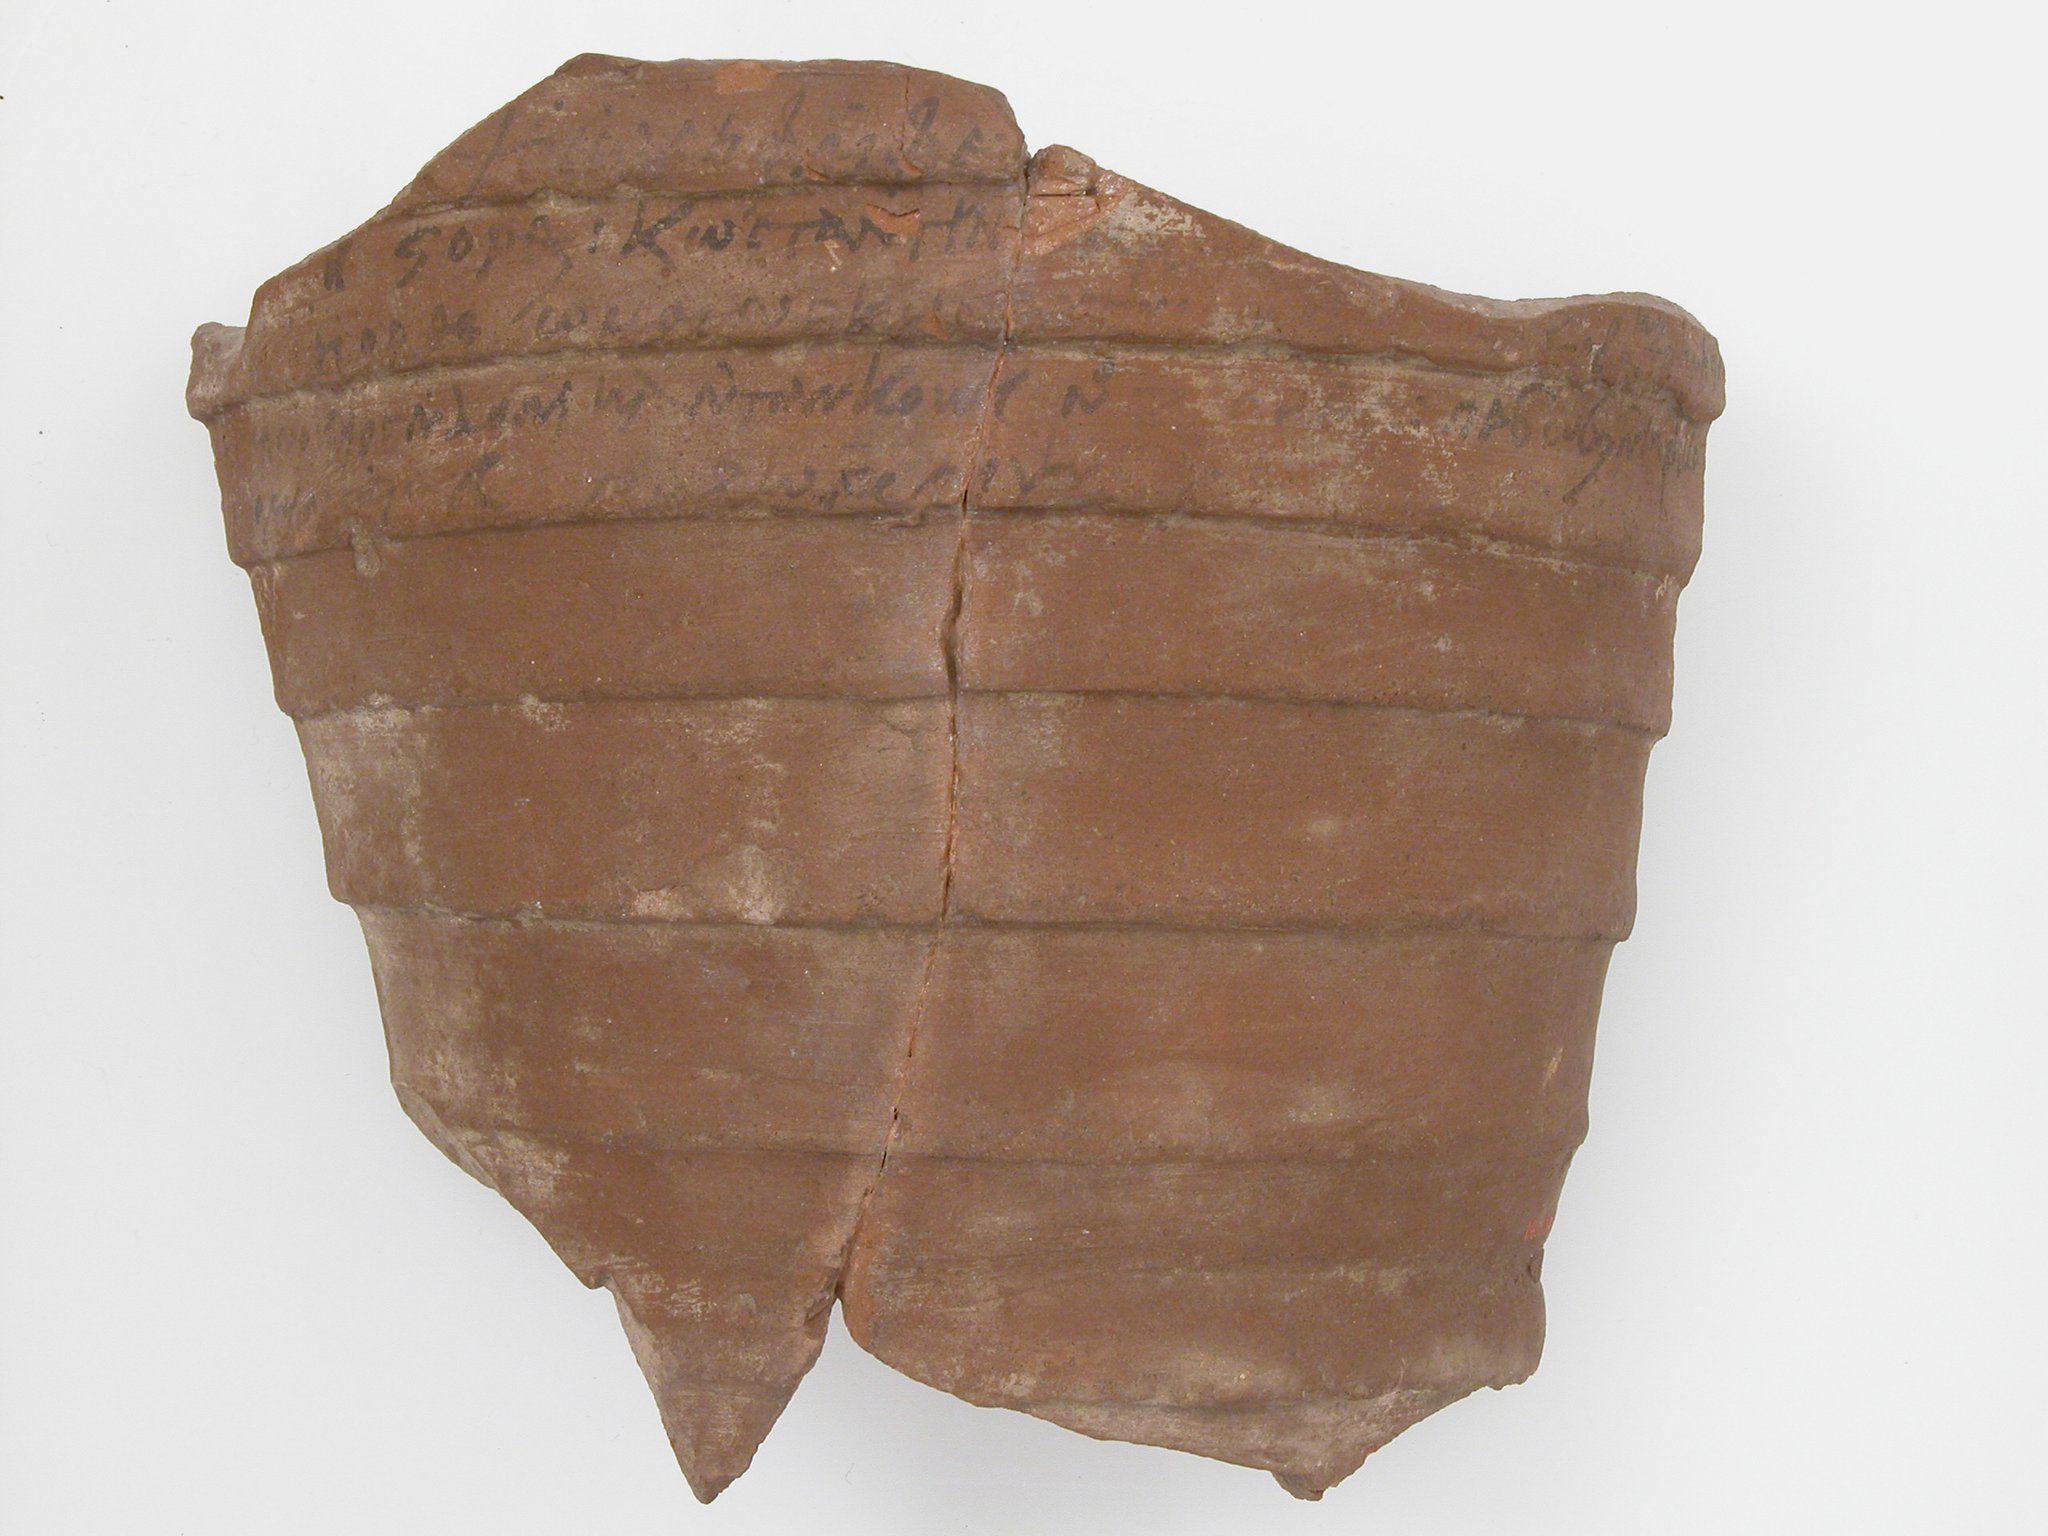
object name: ostrakon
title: Ostrakon with an Account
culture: coptic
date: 600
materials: ink, pottery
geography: egypt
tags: coptic,documents